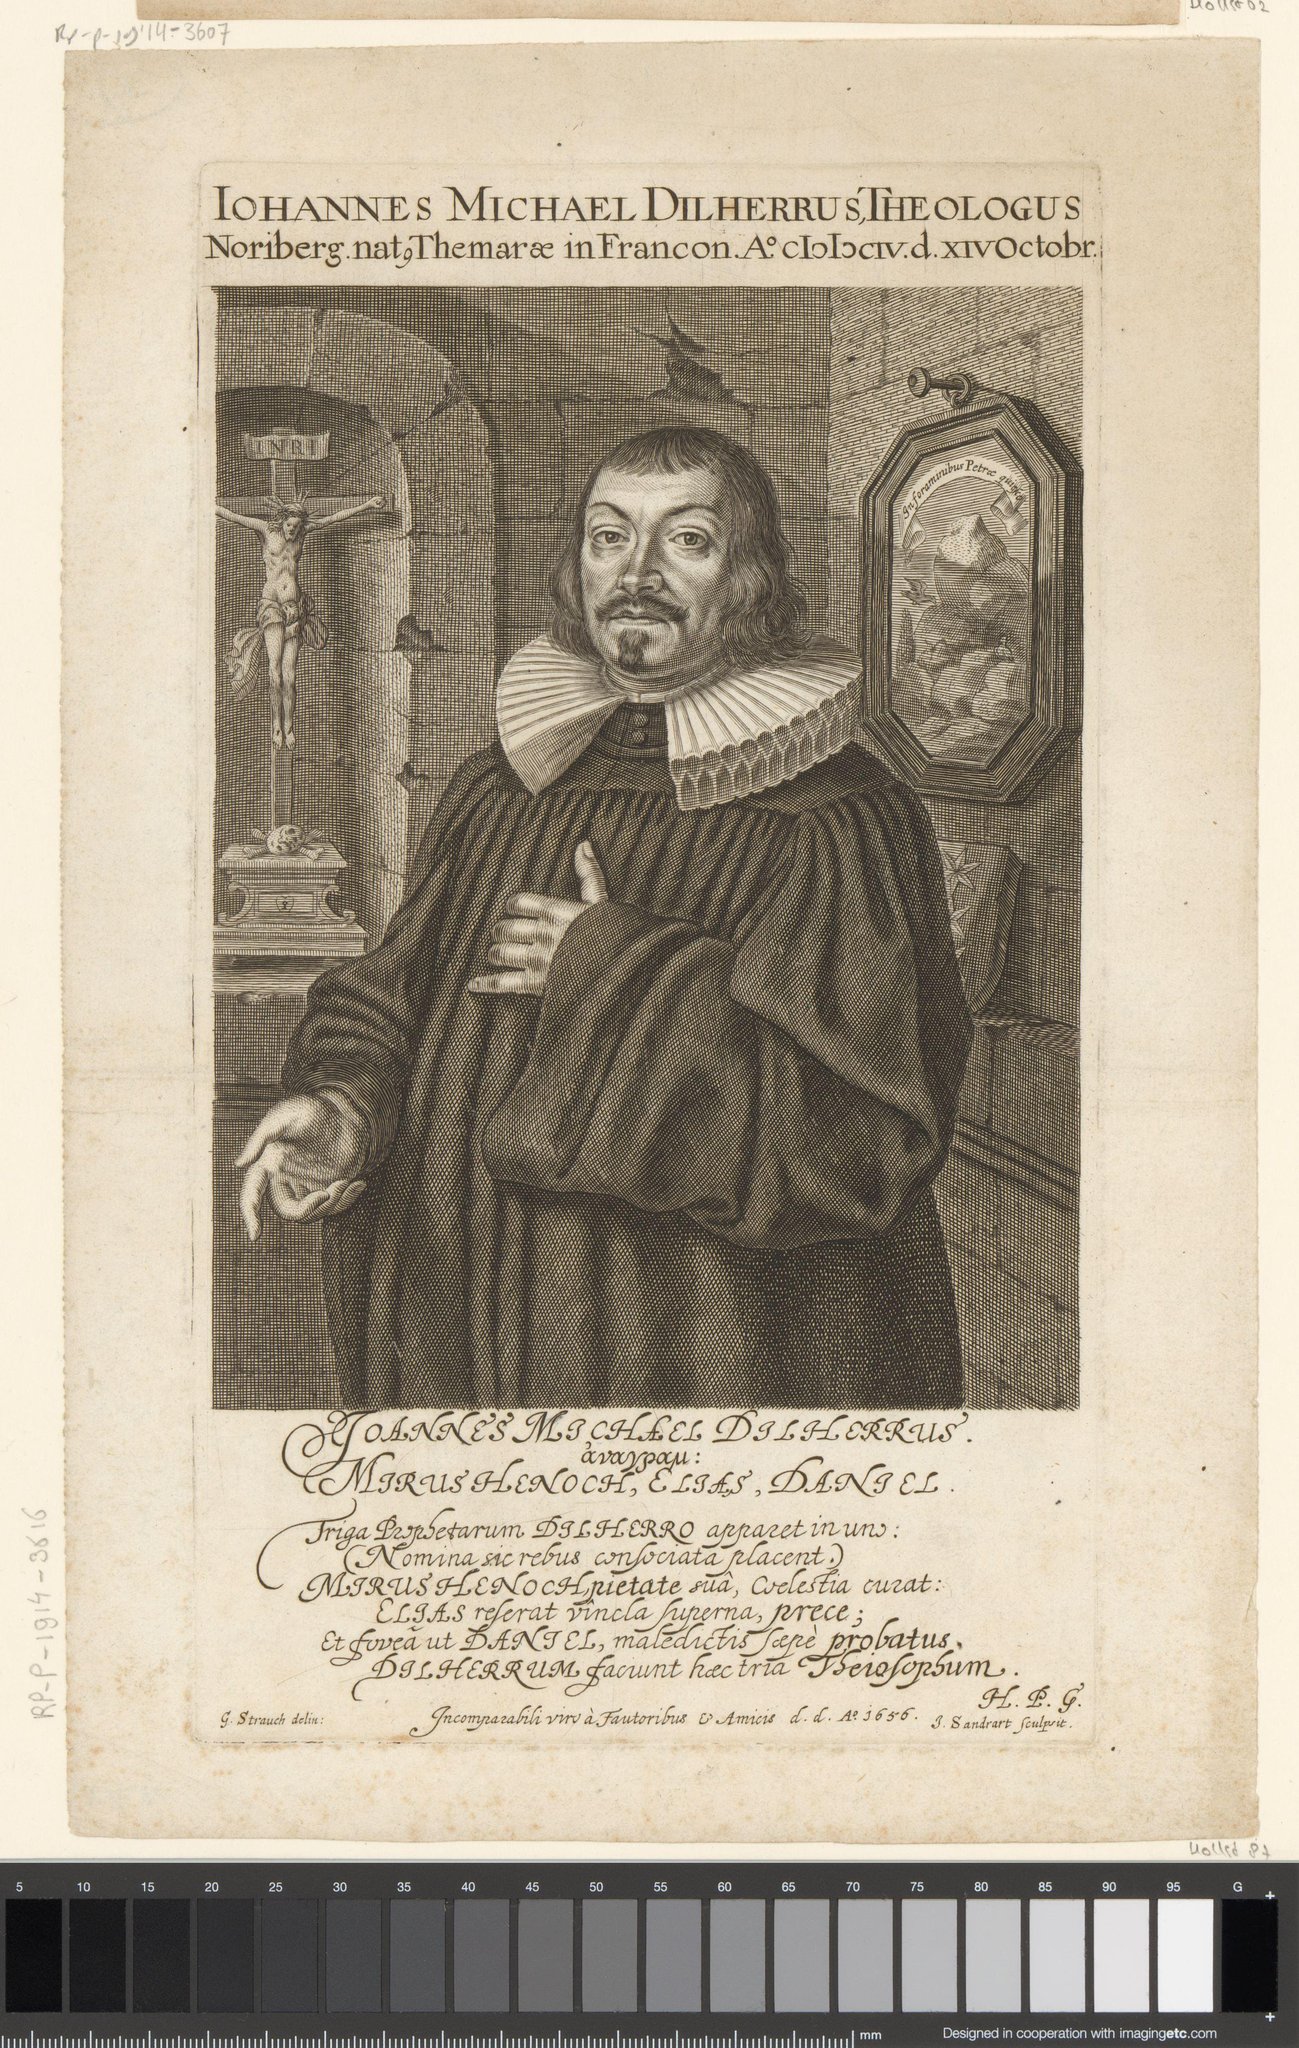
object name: print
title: Portret van Johann Michael Dilherr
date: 1656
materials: paper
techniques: engraving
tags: johann michael dilherr, theologian, historical persons, crucifix ~ personal devotion, abstract ideas and concepts (+ emblematical representation of concept)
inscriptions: collector's mark: Lugt 2228